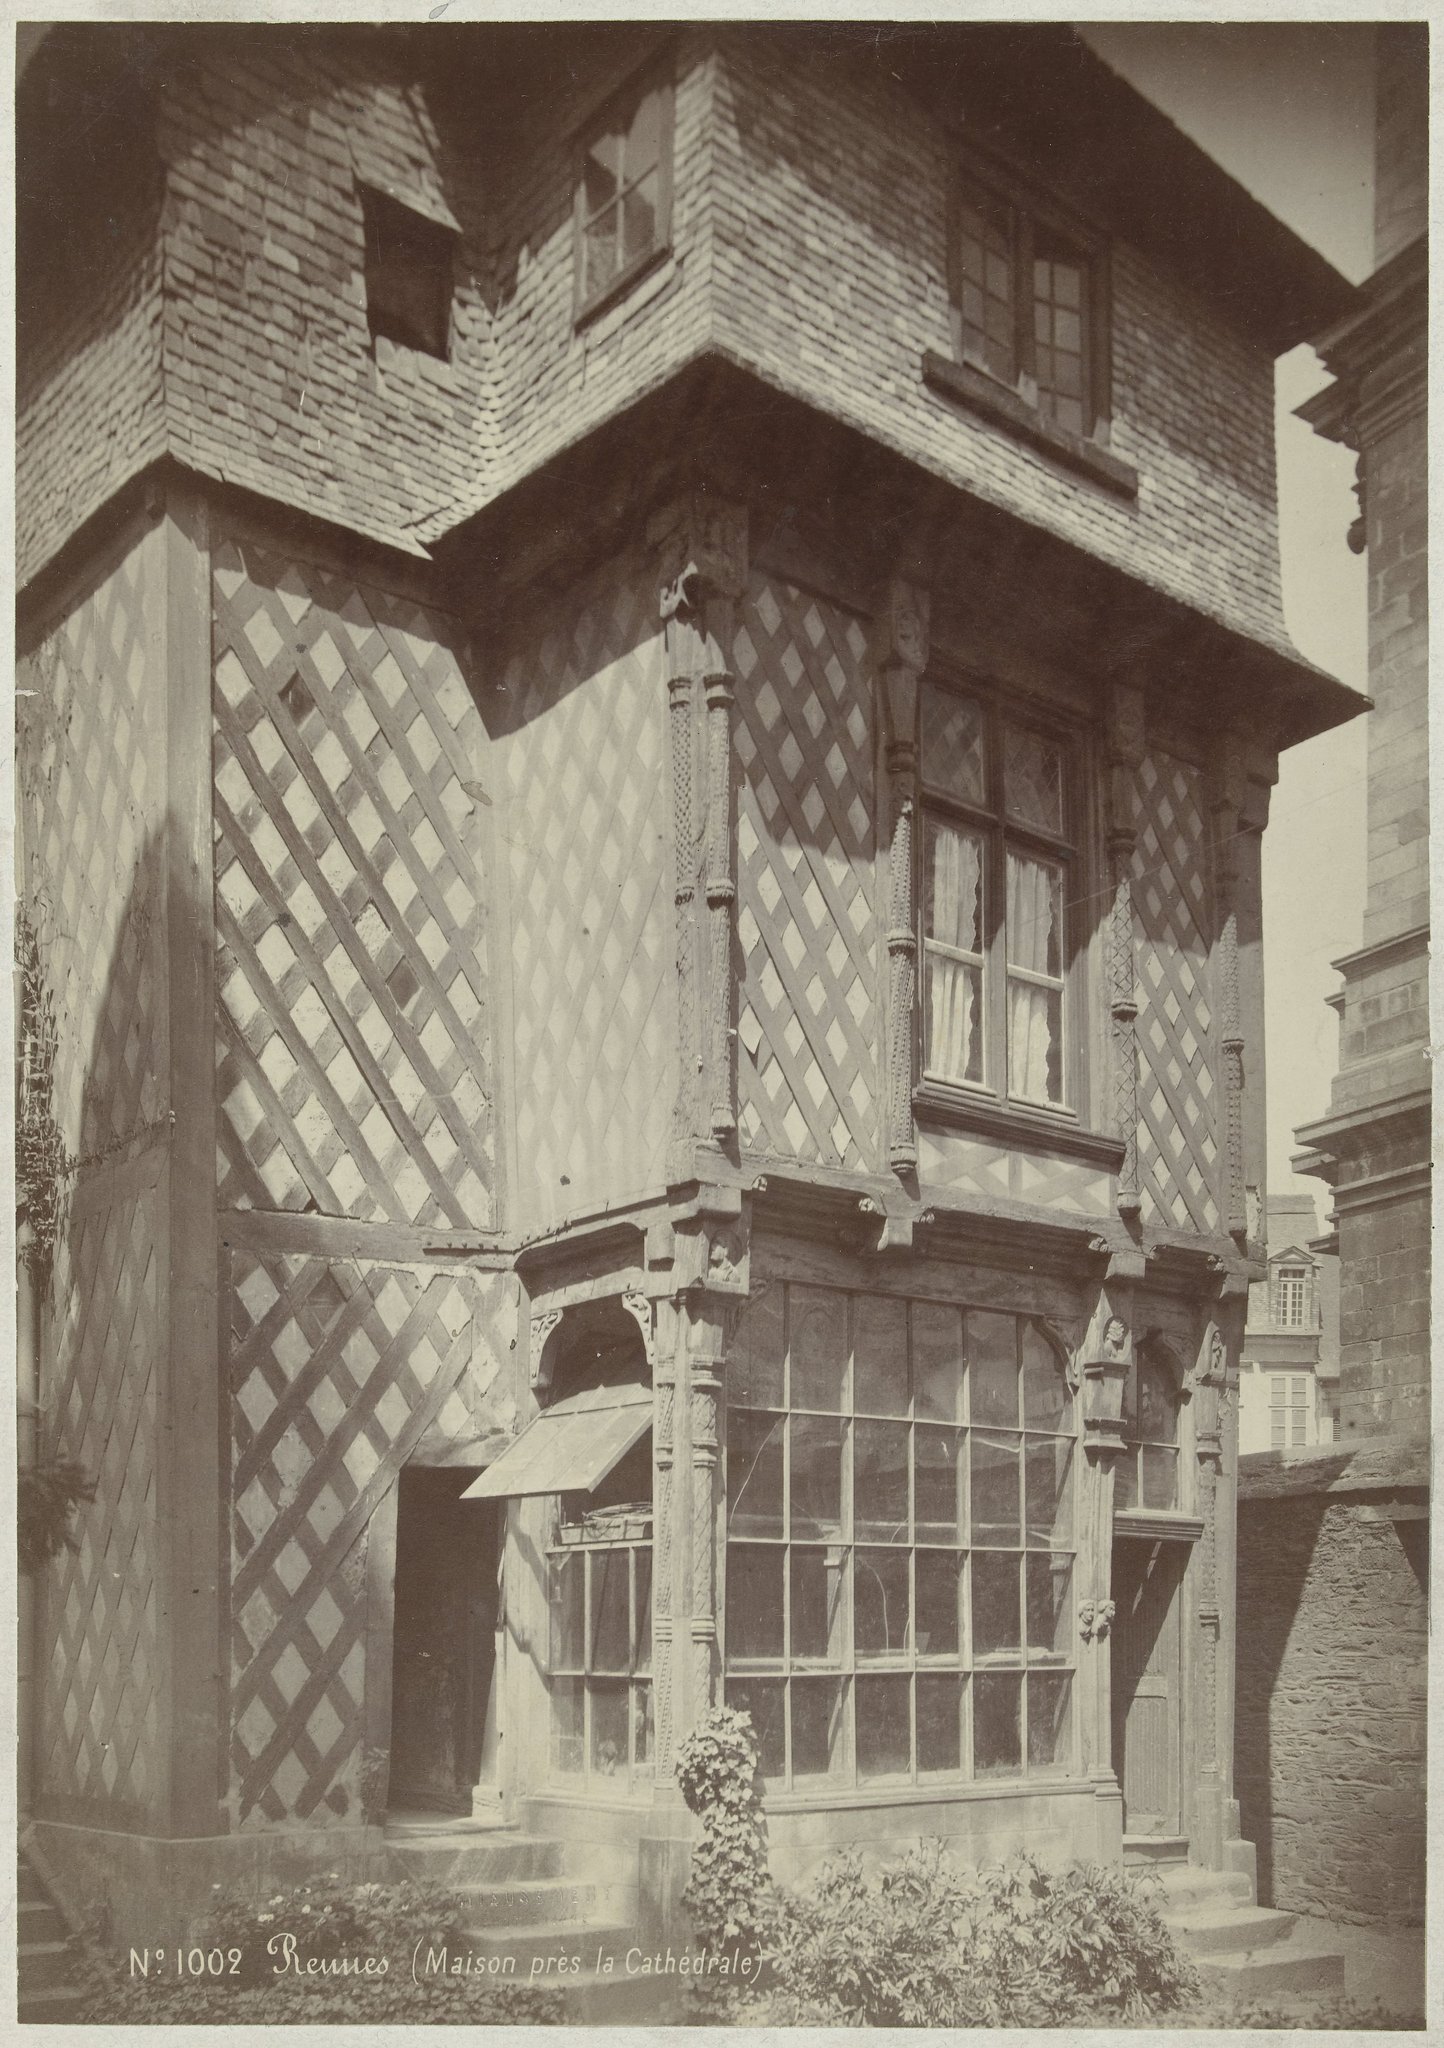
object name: photograph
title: Rennes (Maison près la Cathédrale)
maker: séraphin-médéric mieusement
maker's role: fotograaf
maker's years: 1840-1905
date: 1870-1890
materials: cardboard, paper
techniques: albumen print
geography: rennes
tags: urban housing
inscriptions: check stamp: ‘[...]’, check stamp: ‘Mieusement/ Photographe’, inscription: ‘No. 1002 Rennes (Maison près la Cathédrale)’, collector's mark: Lugt 3937